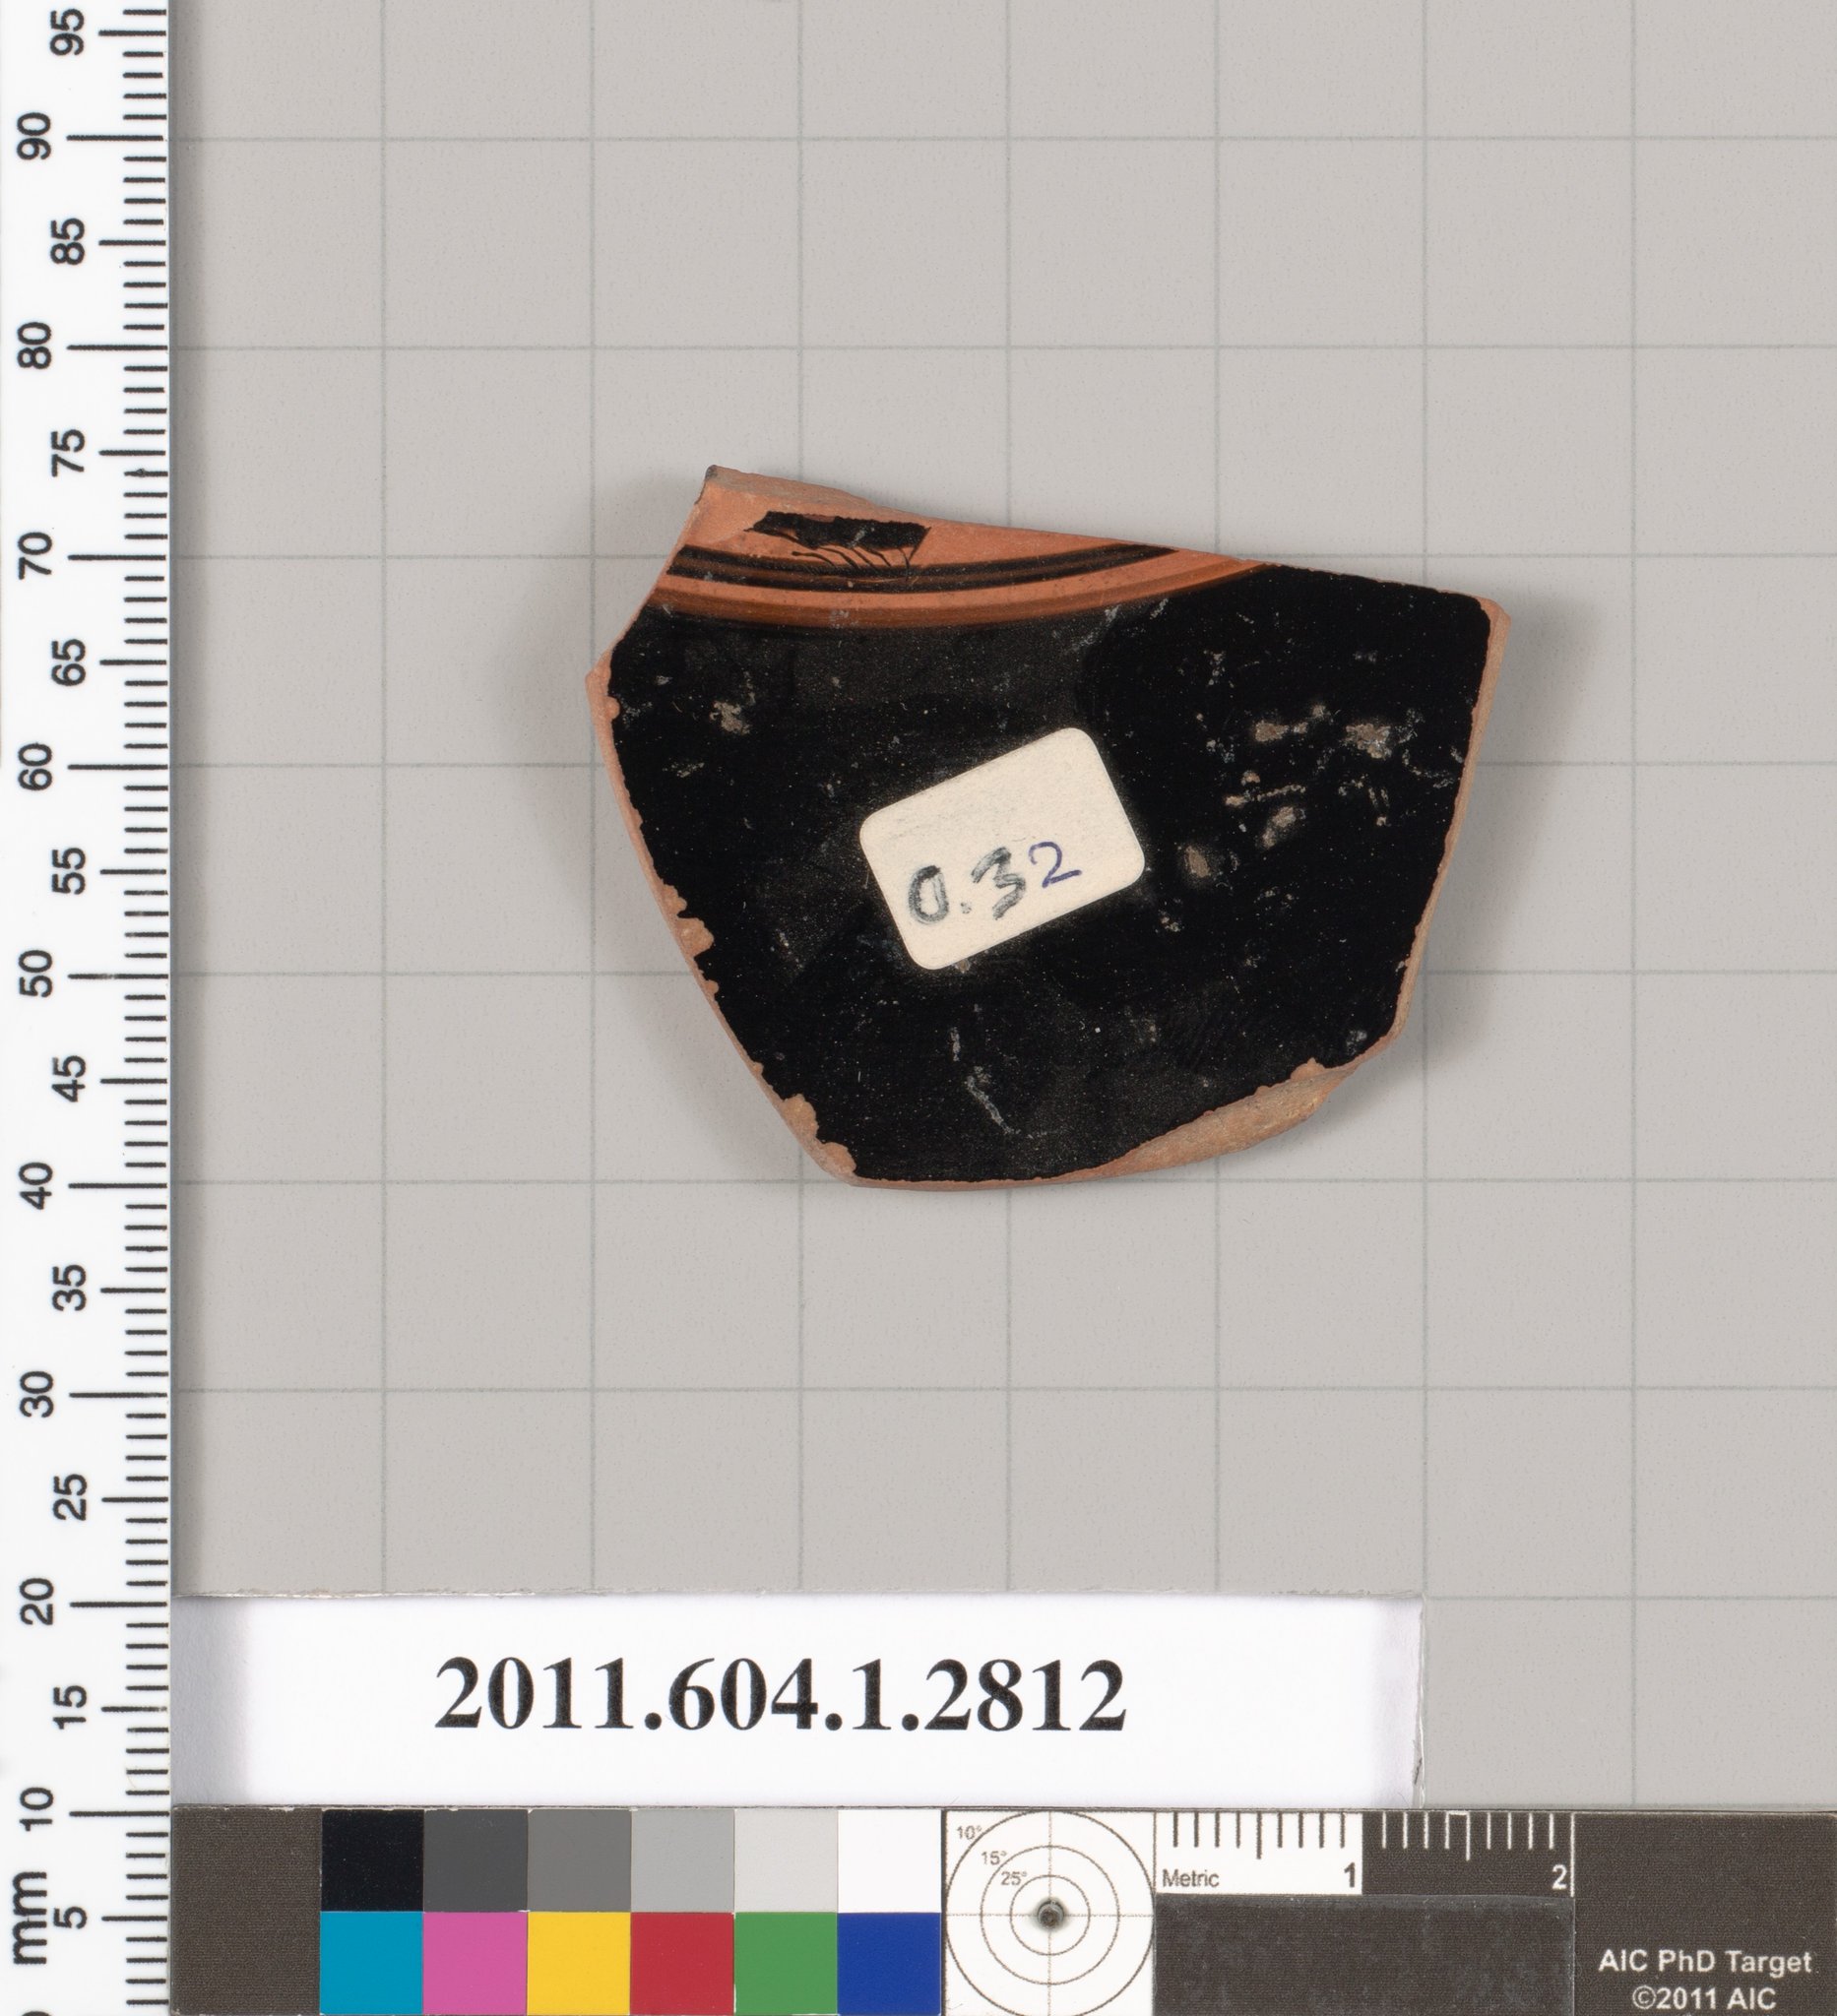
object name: kylix fragment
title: Terracotta fragment of a kylix (drinking cup)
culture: greek, attic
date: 520-490 BCE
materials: terracotta